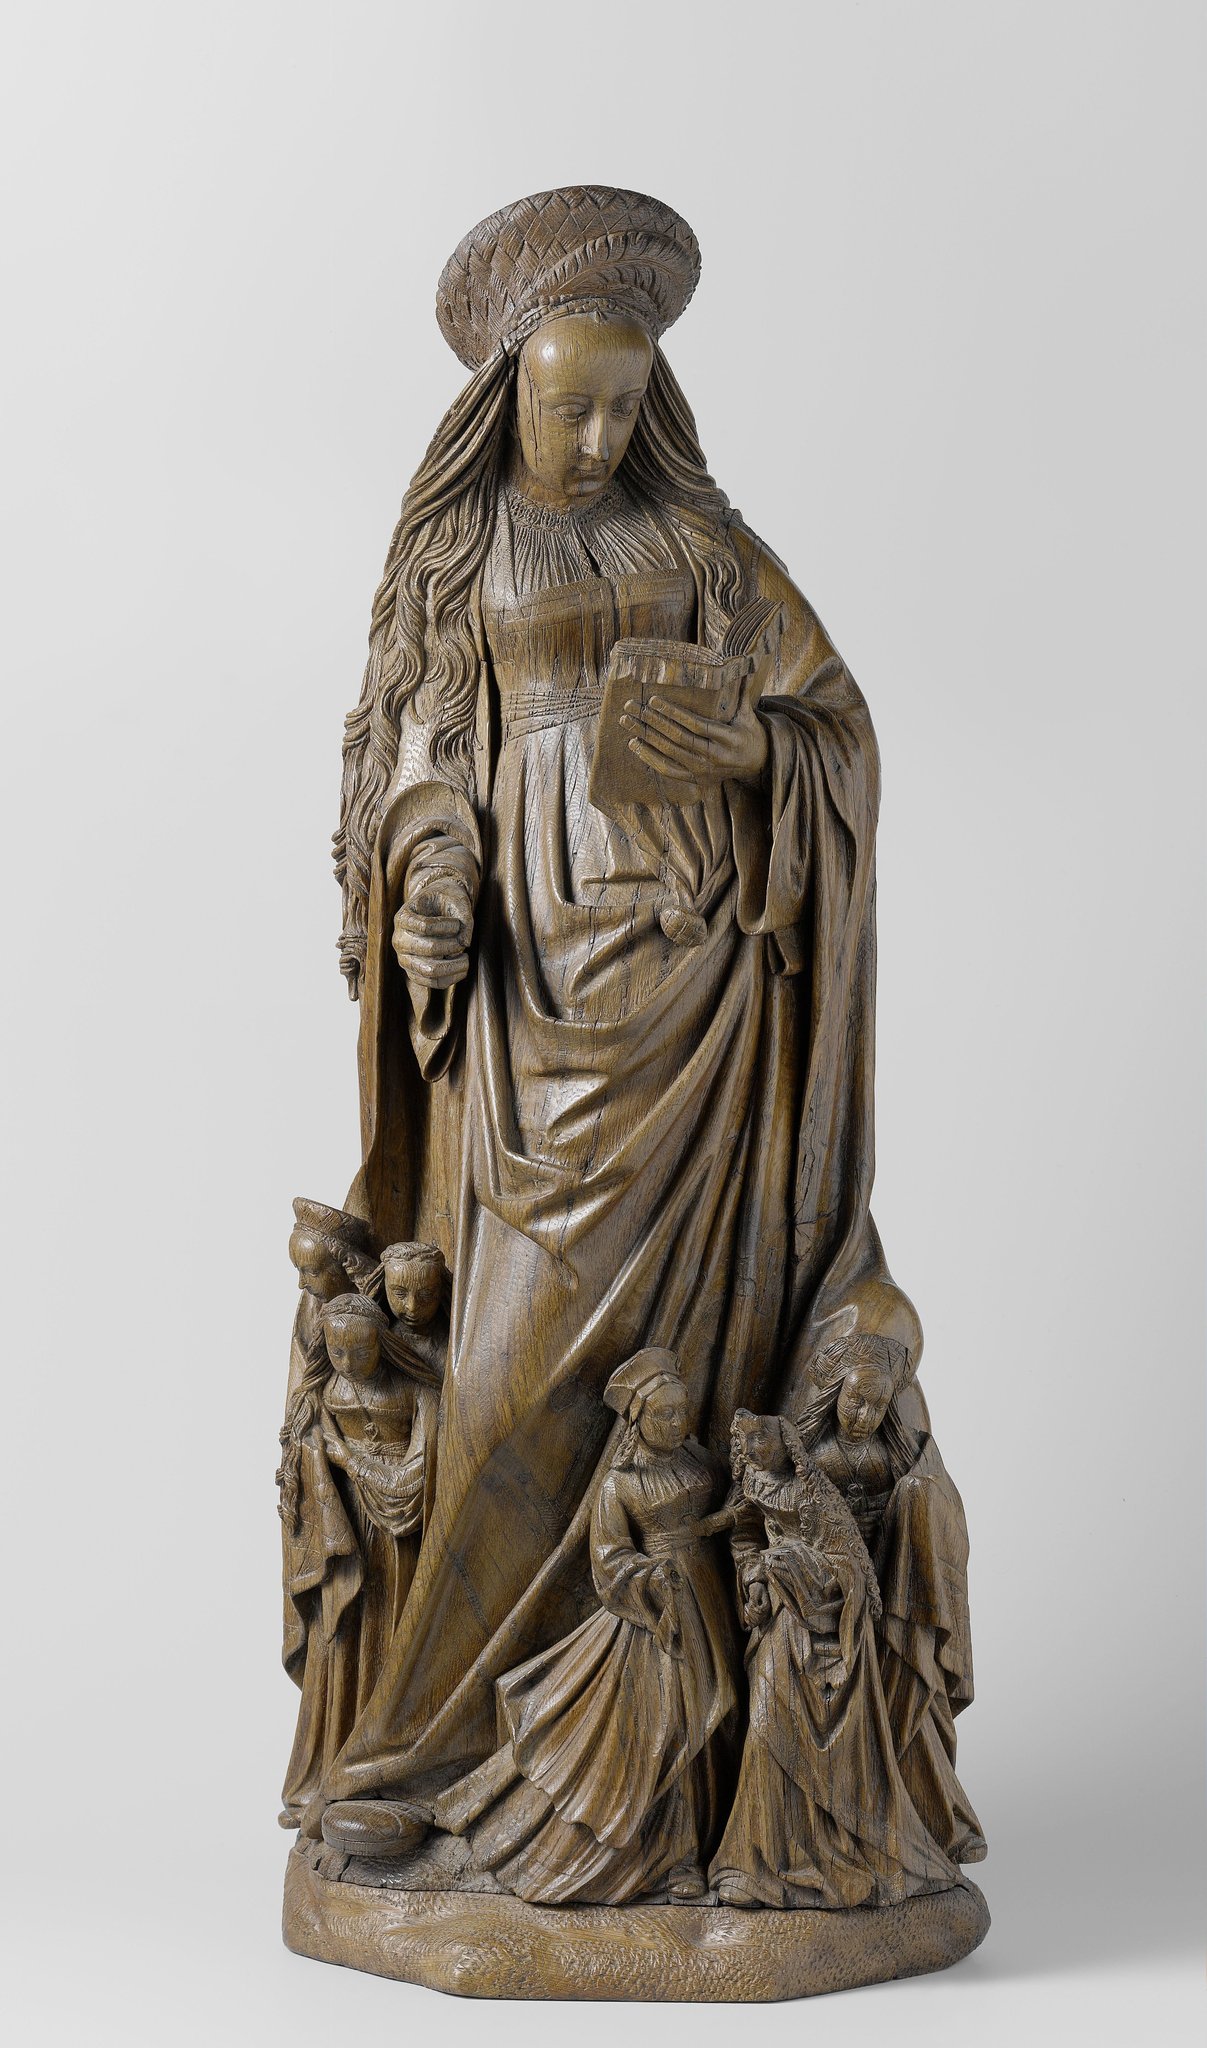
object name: figure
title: Saint Ursula and her Virgins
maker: henrik douverman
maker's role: sculptor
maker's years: 1480-1544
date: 1520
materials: wood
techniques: polychromy, carved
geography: kalkar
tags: the virgin martyr ursula of cologne; possible attributes: arrow, banner with red cross, cloak of ermine, crown, ship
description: The Christian princess Ursula was murdered by Huns near Cologne together with her retinue of 11,000 virginal handmaidens. Some of them seek protection under Ursula’s gown in this sculpture. The saint is dressed as a well-to-do lady in the high fashion of the day: with a braided linen headdress and a ‘guimpe’ (a thin chemisette worn under a low-necked dress).